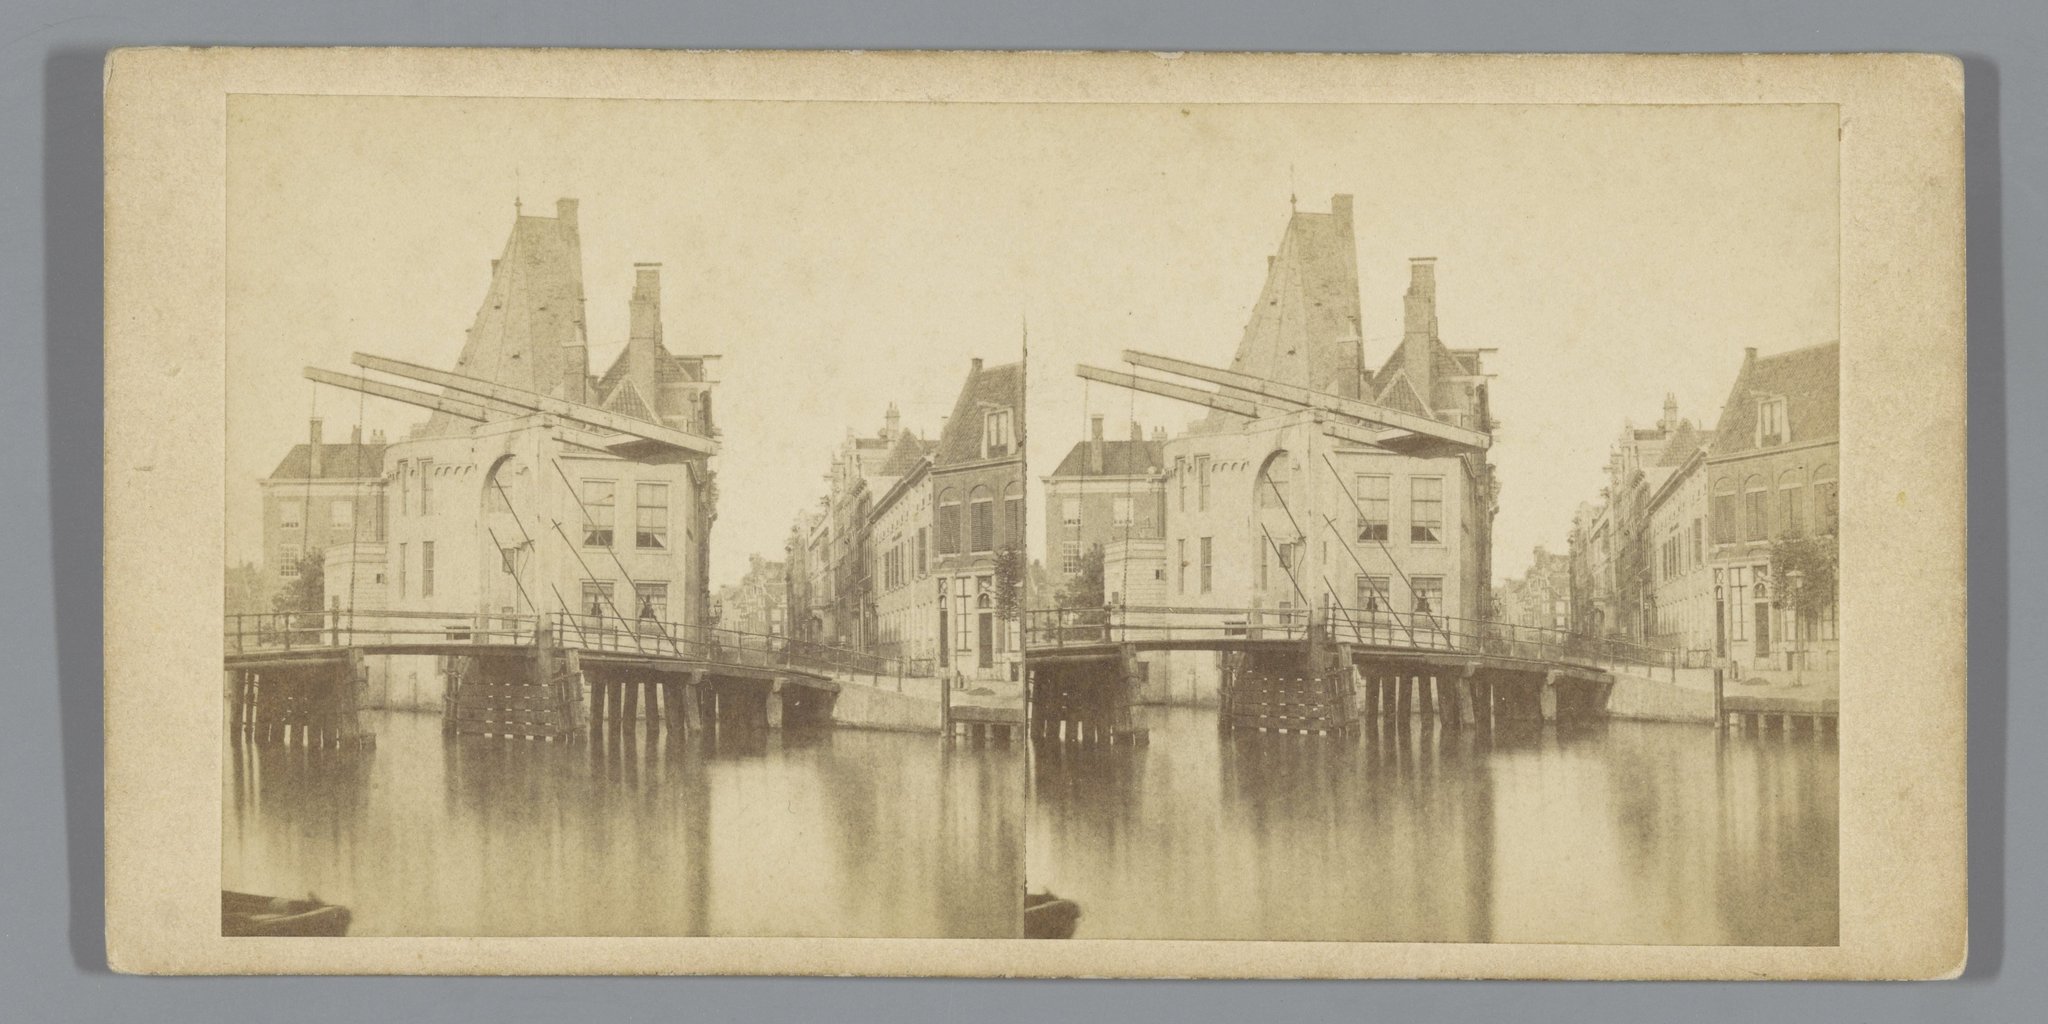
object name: stereograph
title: Den Doelen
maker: pieter oosterhuis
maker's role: draughtsman, print maker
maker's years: 1816-1885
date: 1860-1870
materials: cardboard, paper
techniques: albumen print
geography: amsterdam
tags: bridge in city across river, canal, etc.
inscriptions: number: ‘No. 207.’